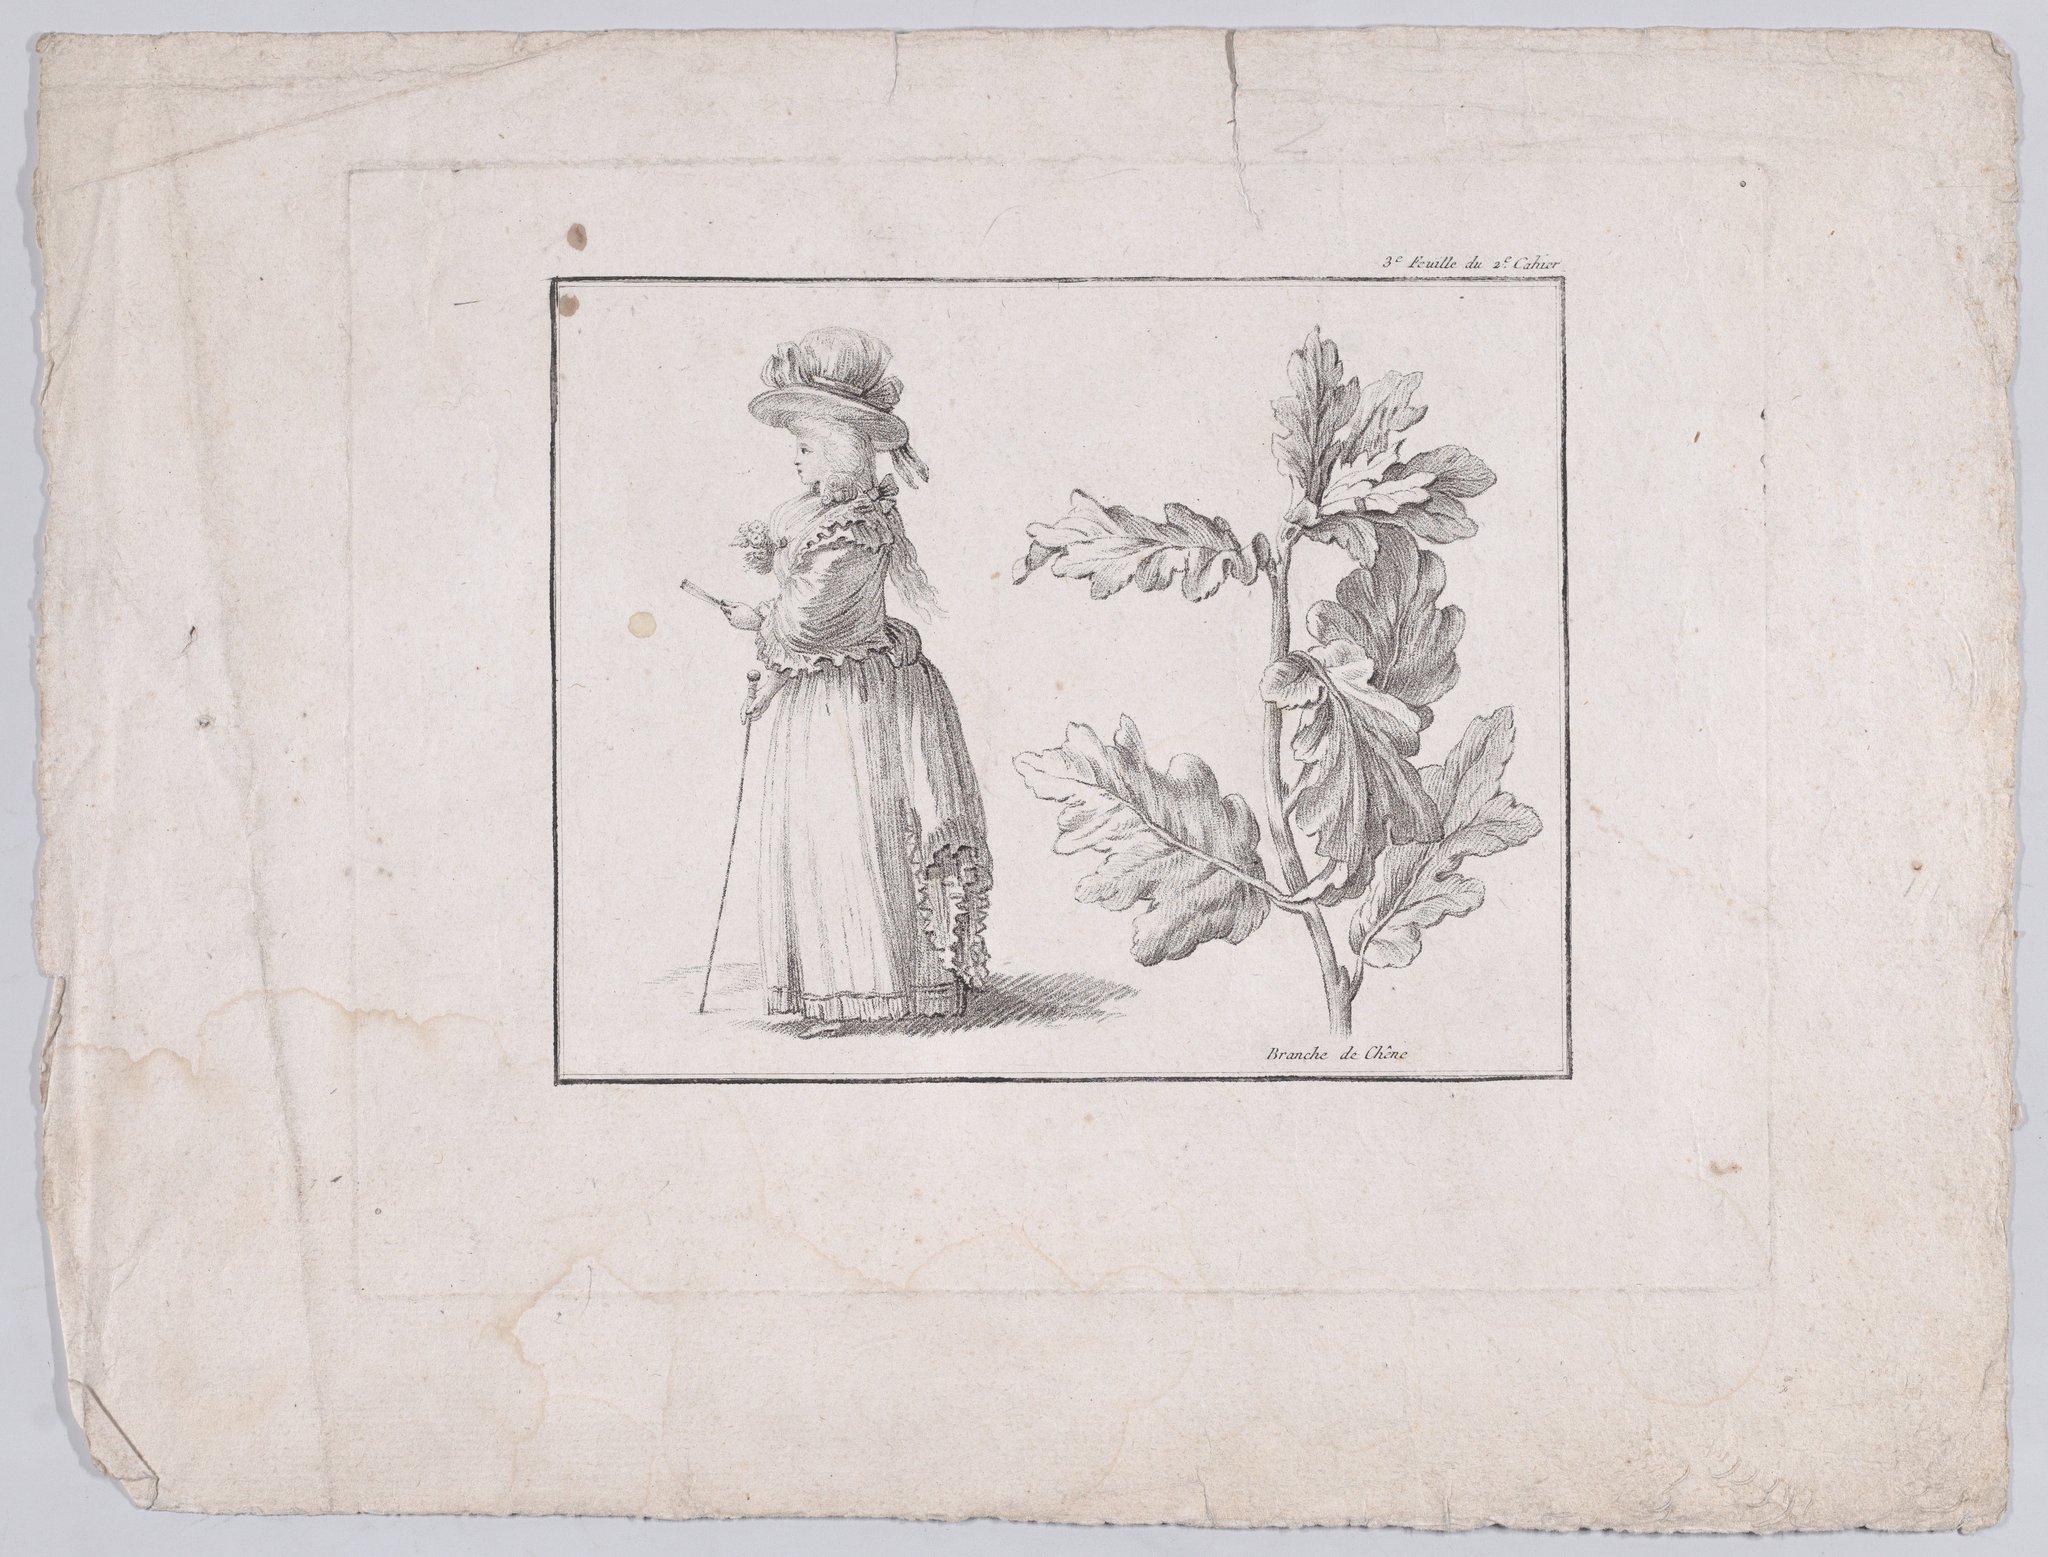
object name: print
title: Profile of a woman and a study of an oak branch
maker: gilles-antoine demarteau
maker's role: artist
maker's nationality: french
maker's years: 1756-1802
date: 1770-1788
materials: ink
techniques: printmaking, etching, printing